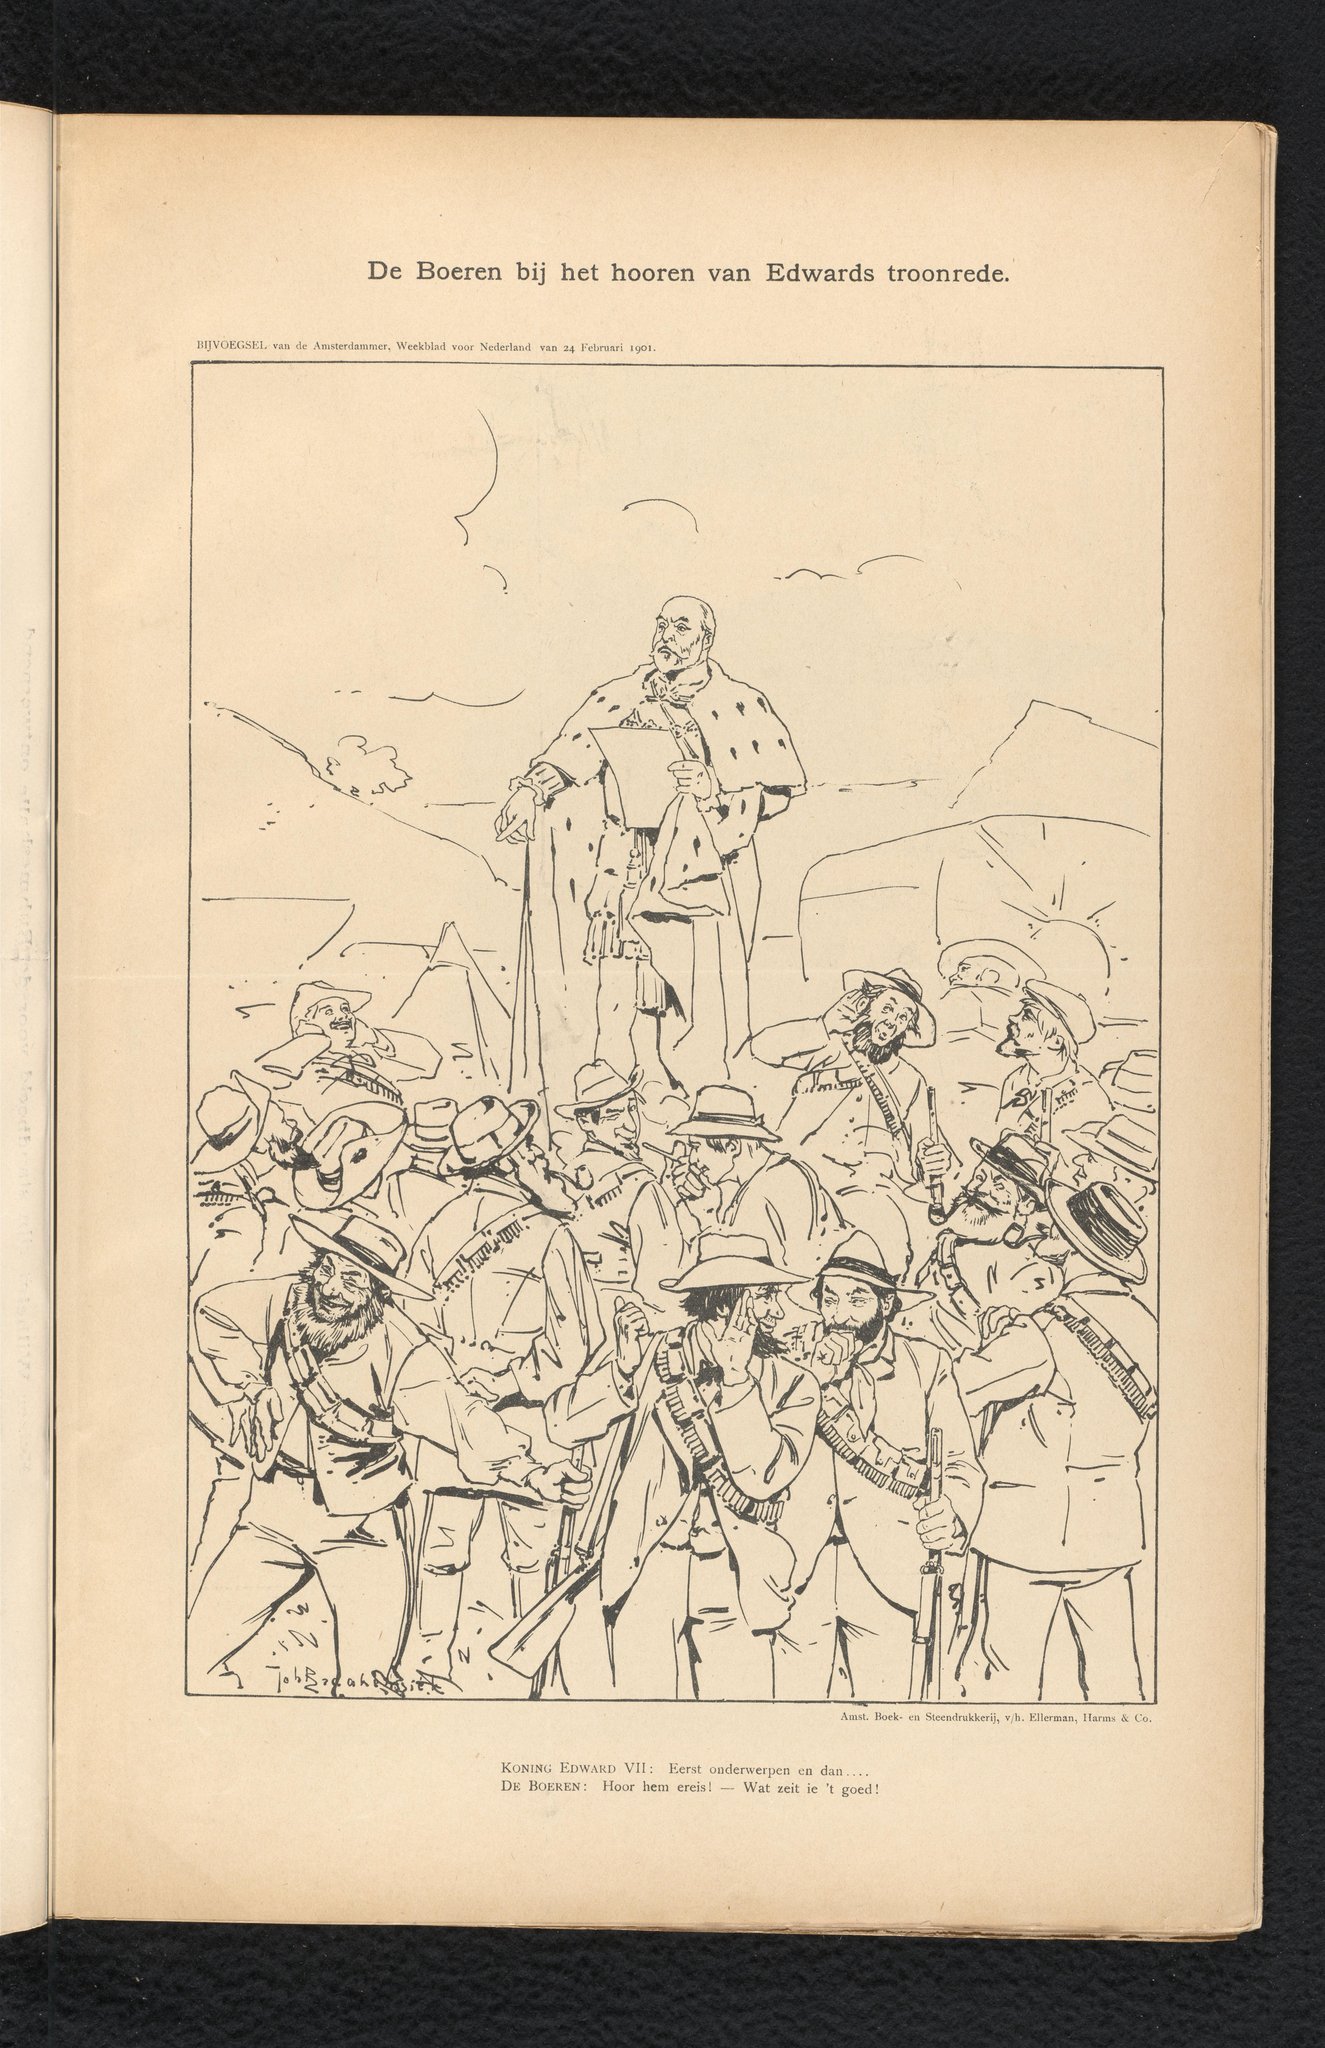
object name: cartoon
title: De Boeren bij het hooren van Edwards troonrede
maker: johan braakensiek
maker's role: draughtsman, print maker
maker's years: 1858-1940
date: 1901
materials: paper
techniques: lithograph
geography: amsterdam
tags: political caricatures and satires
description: De Zuid-Afrikaanse Boeren lachen om de troonrede van de Engelse koning Edward VII, uitgesproken in februari 1901.